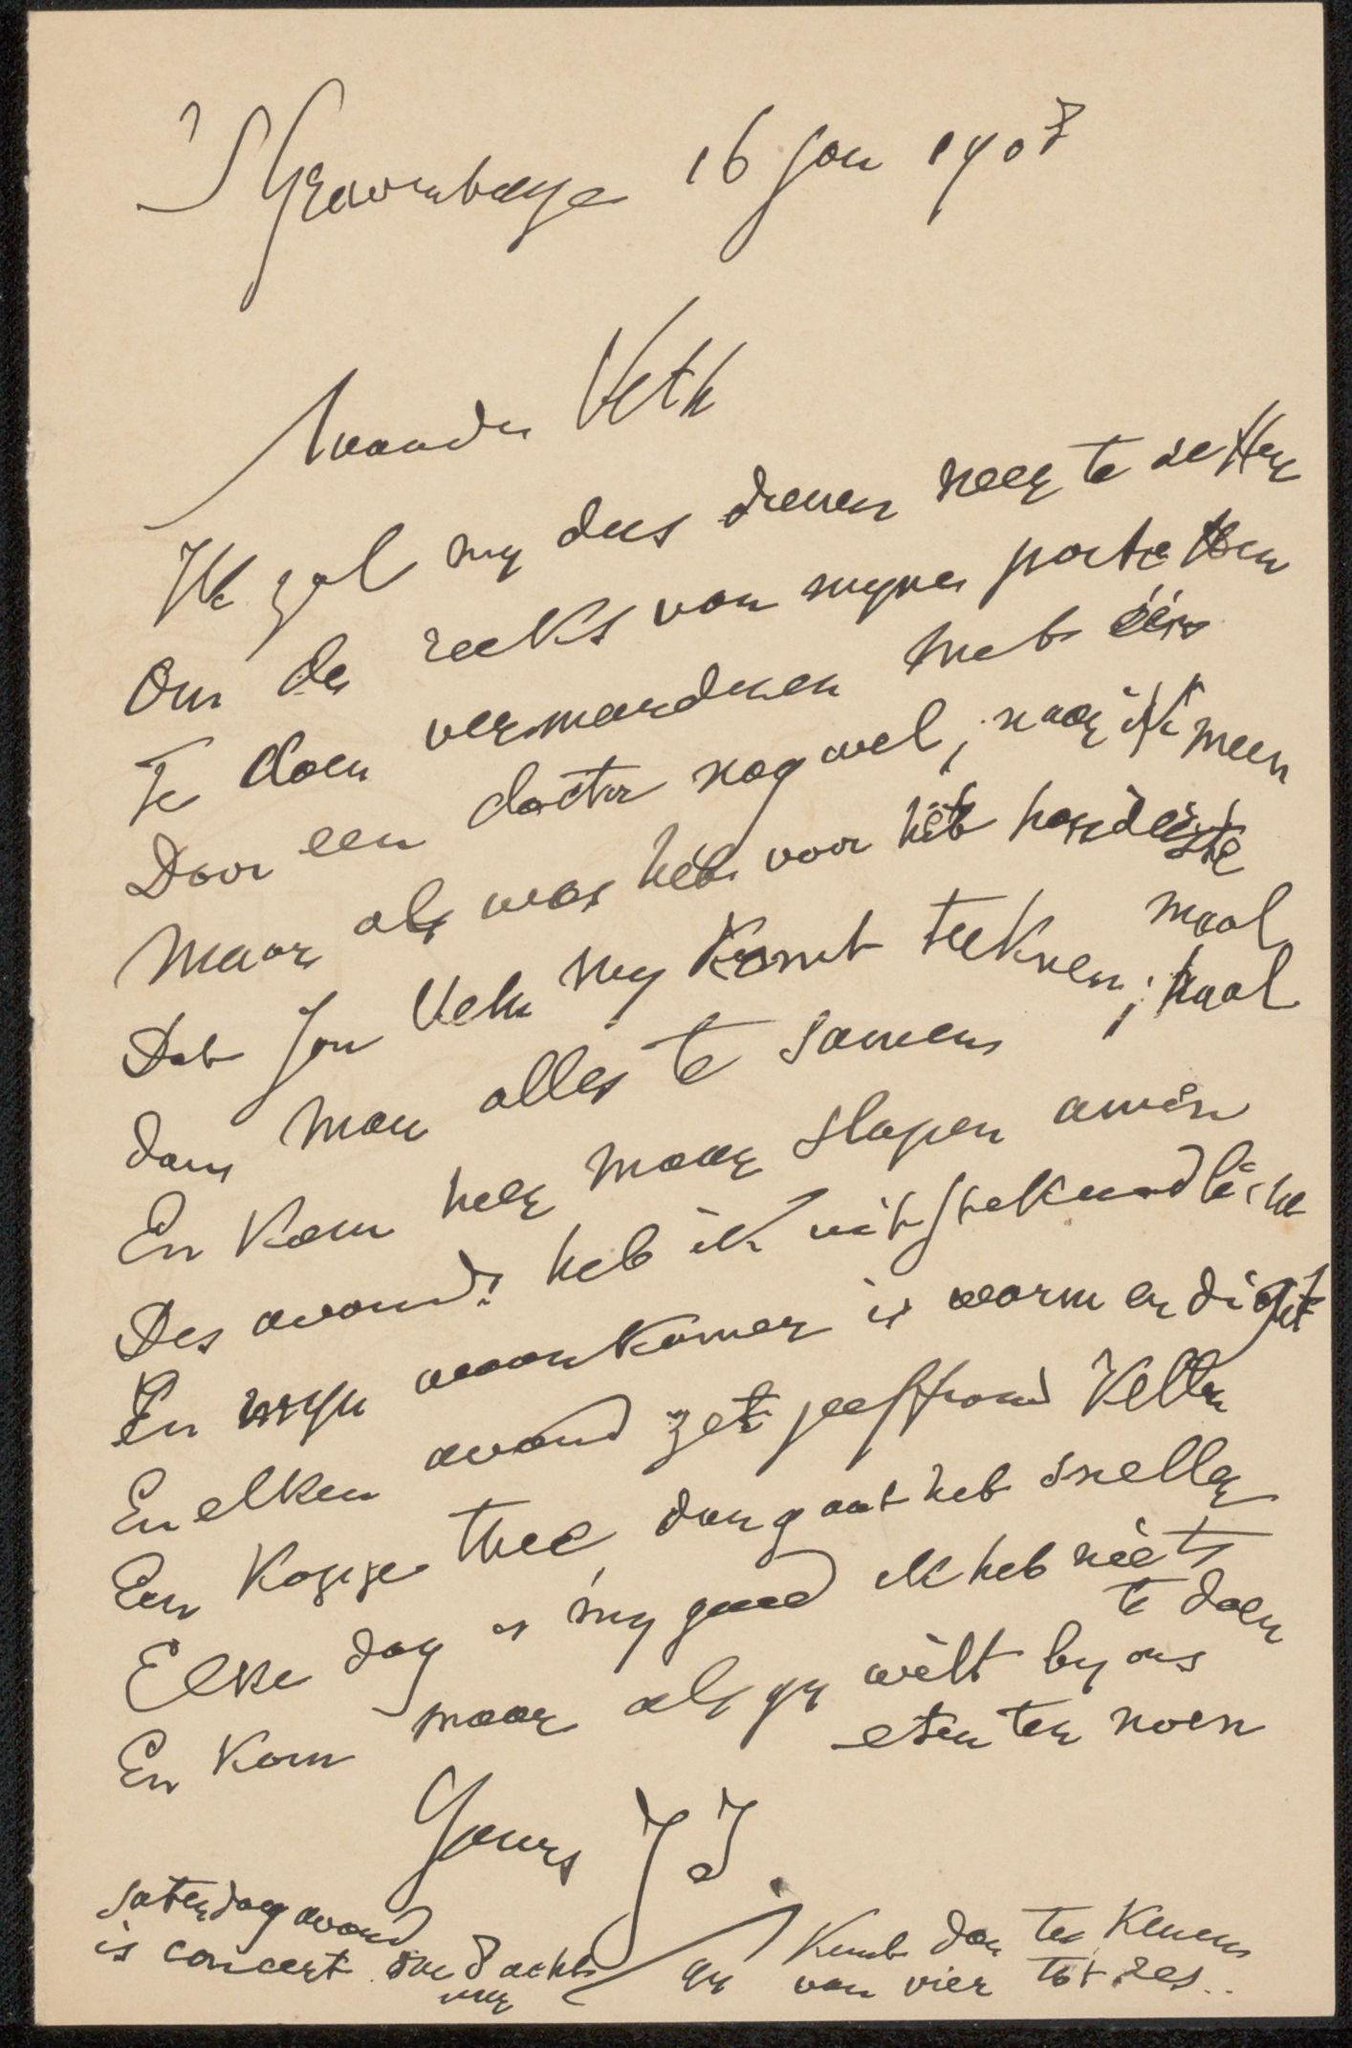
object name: letter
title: Brief aan Jan Veth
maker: jozef israëls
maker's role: draughtsman, painter, print maker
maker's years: 1824-1911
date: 1908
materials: ink, paper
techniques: pen, writing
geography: the hague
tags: dordrecht, amsterdam, painter, print maker, draughtsman, designer, jan veth, historical persons (portraits and scenes from the life)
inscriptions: collector's mark: ‘RPK’, watermark